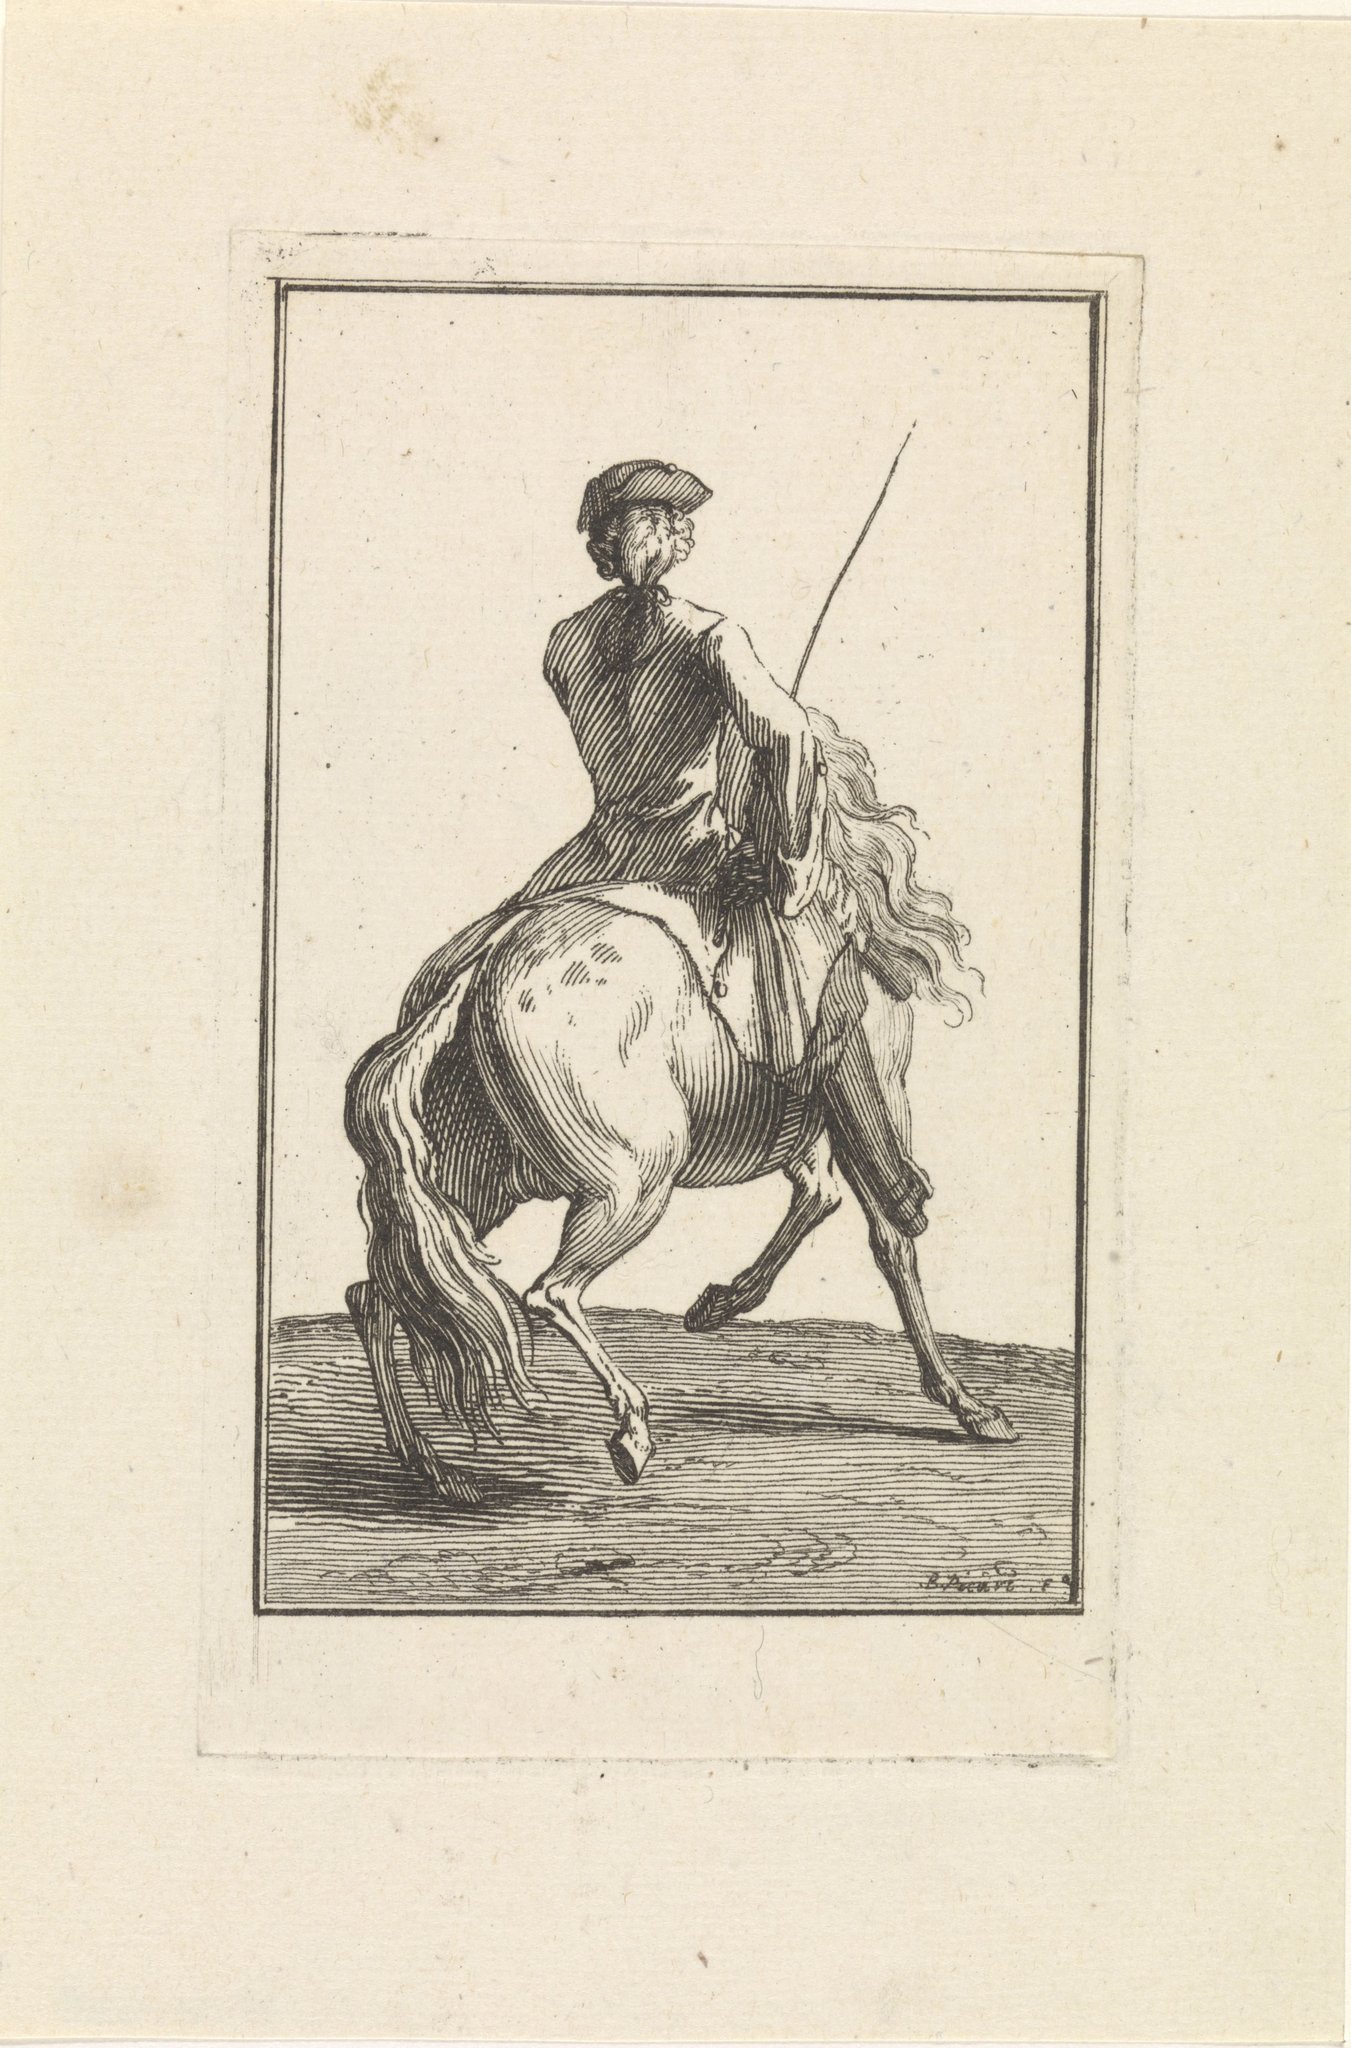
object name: print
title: Ruiter, op de rug gezien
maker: bernard picart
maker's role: draughtsman, print maker, publisher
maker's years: 1673-1733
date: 1683-1733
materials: paper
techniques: engraving, etching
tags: riding a horse, ass, or mule; rider, horseman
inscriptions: collector's mark: Lugt 2228